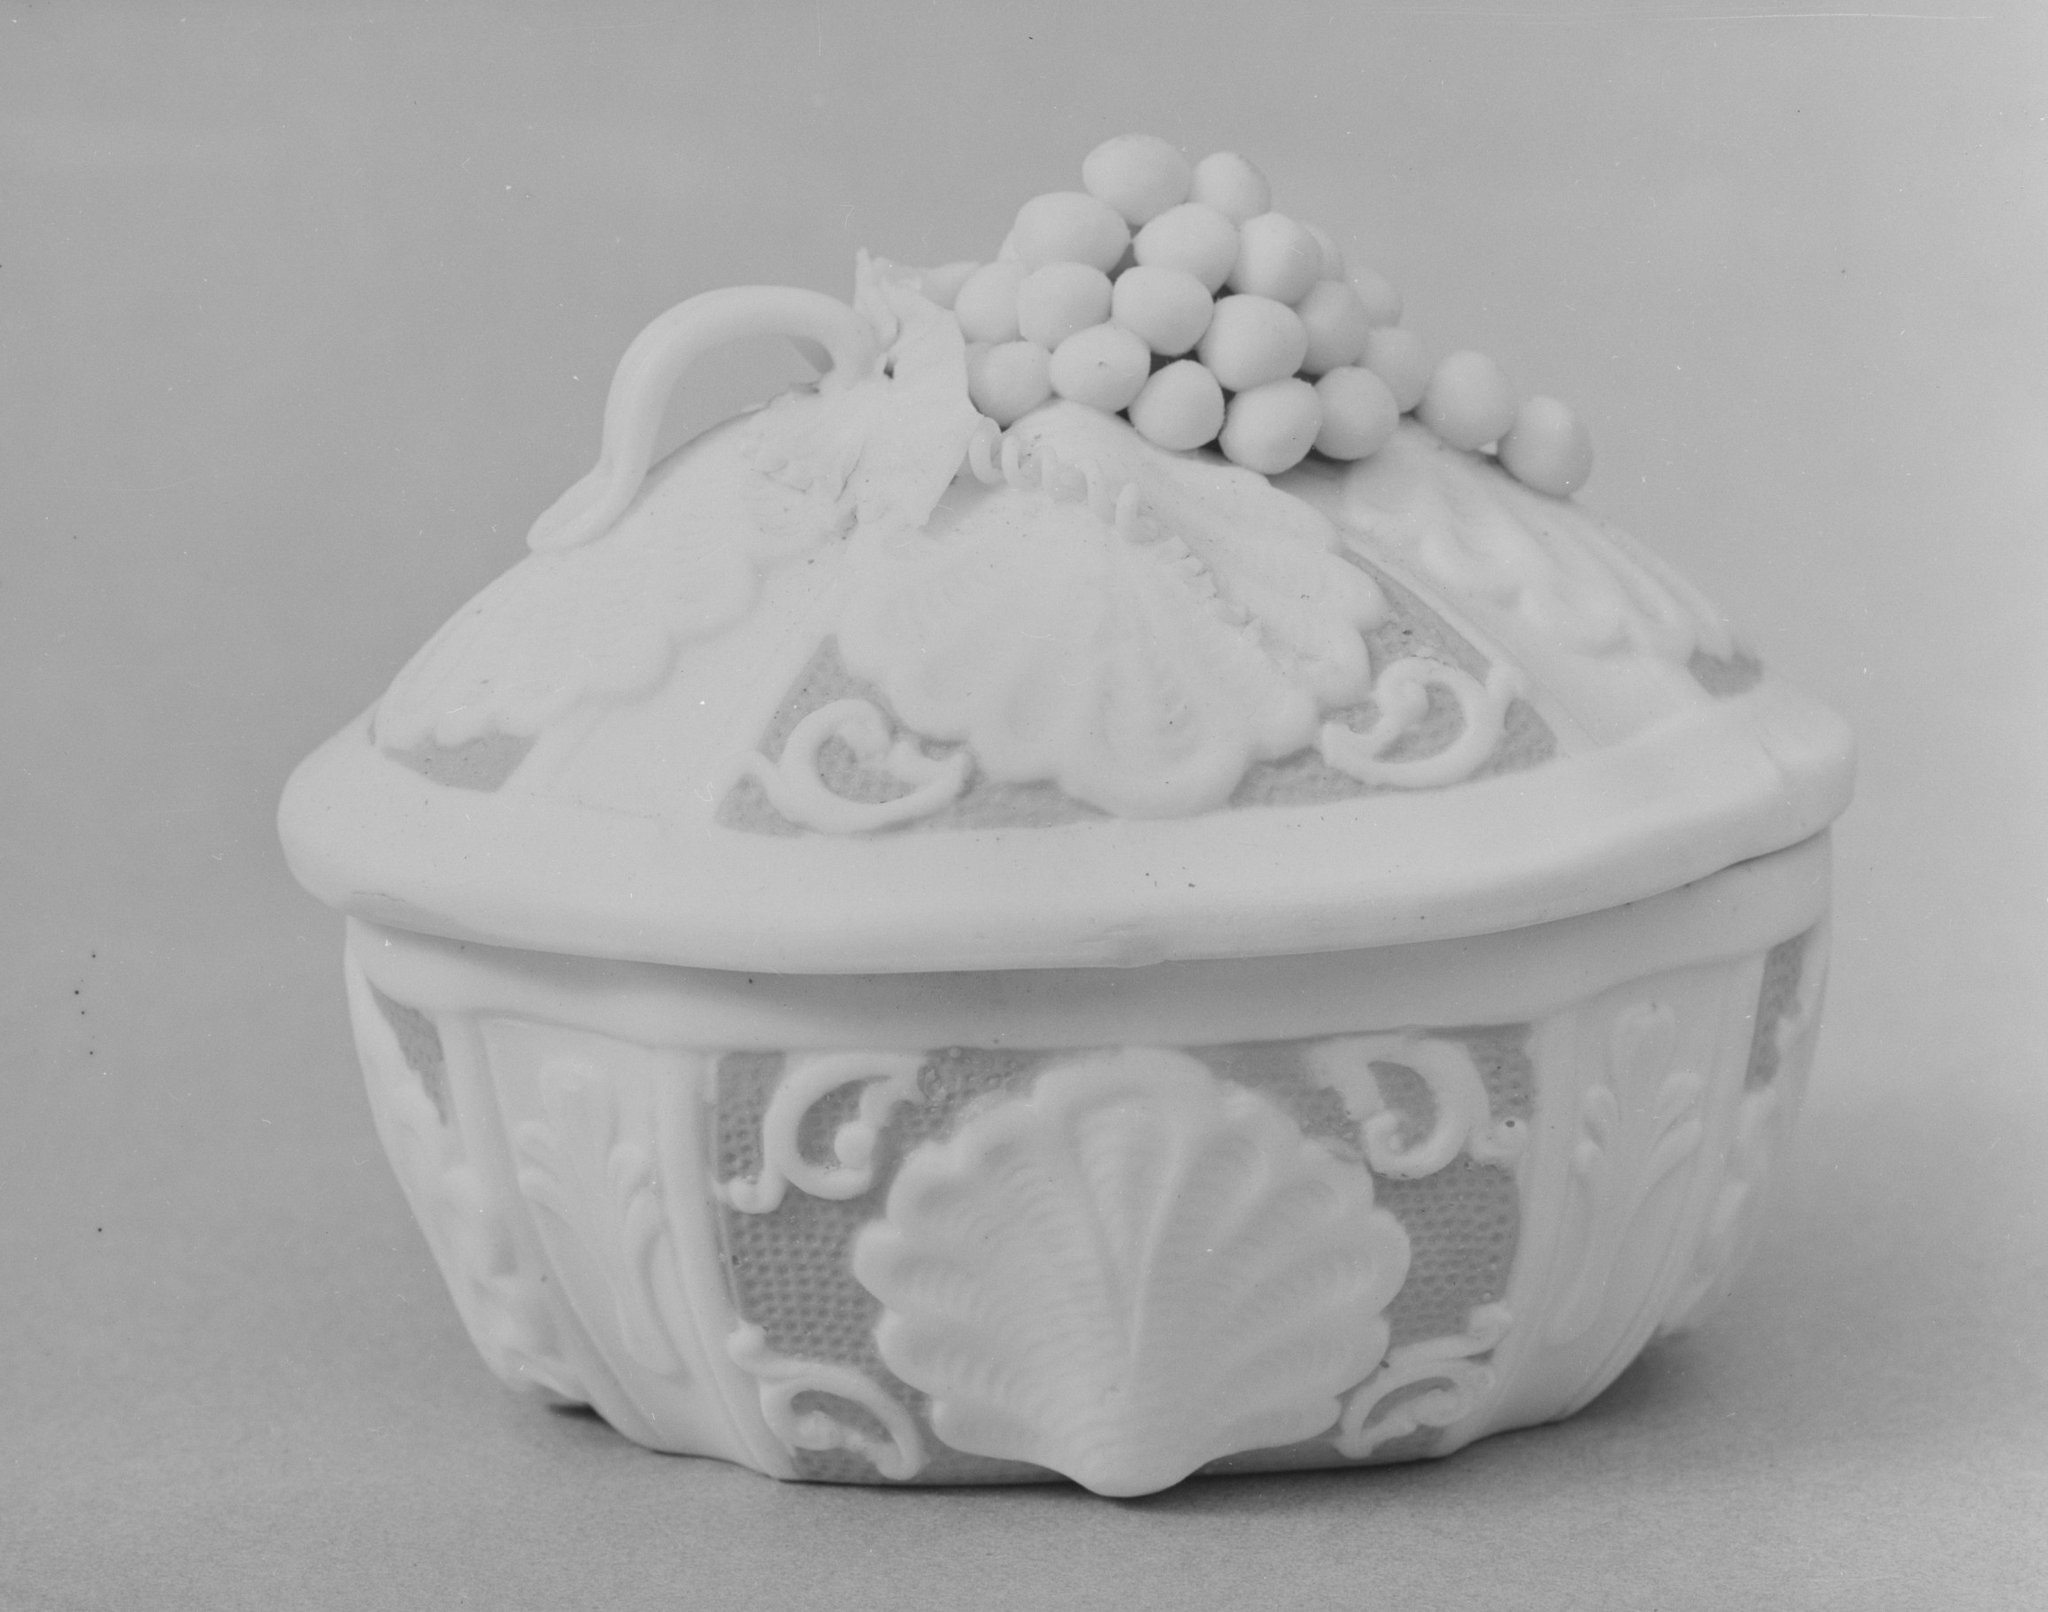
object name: box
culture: american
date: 1830-1870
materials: porcelain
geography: united states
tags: grapes